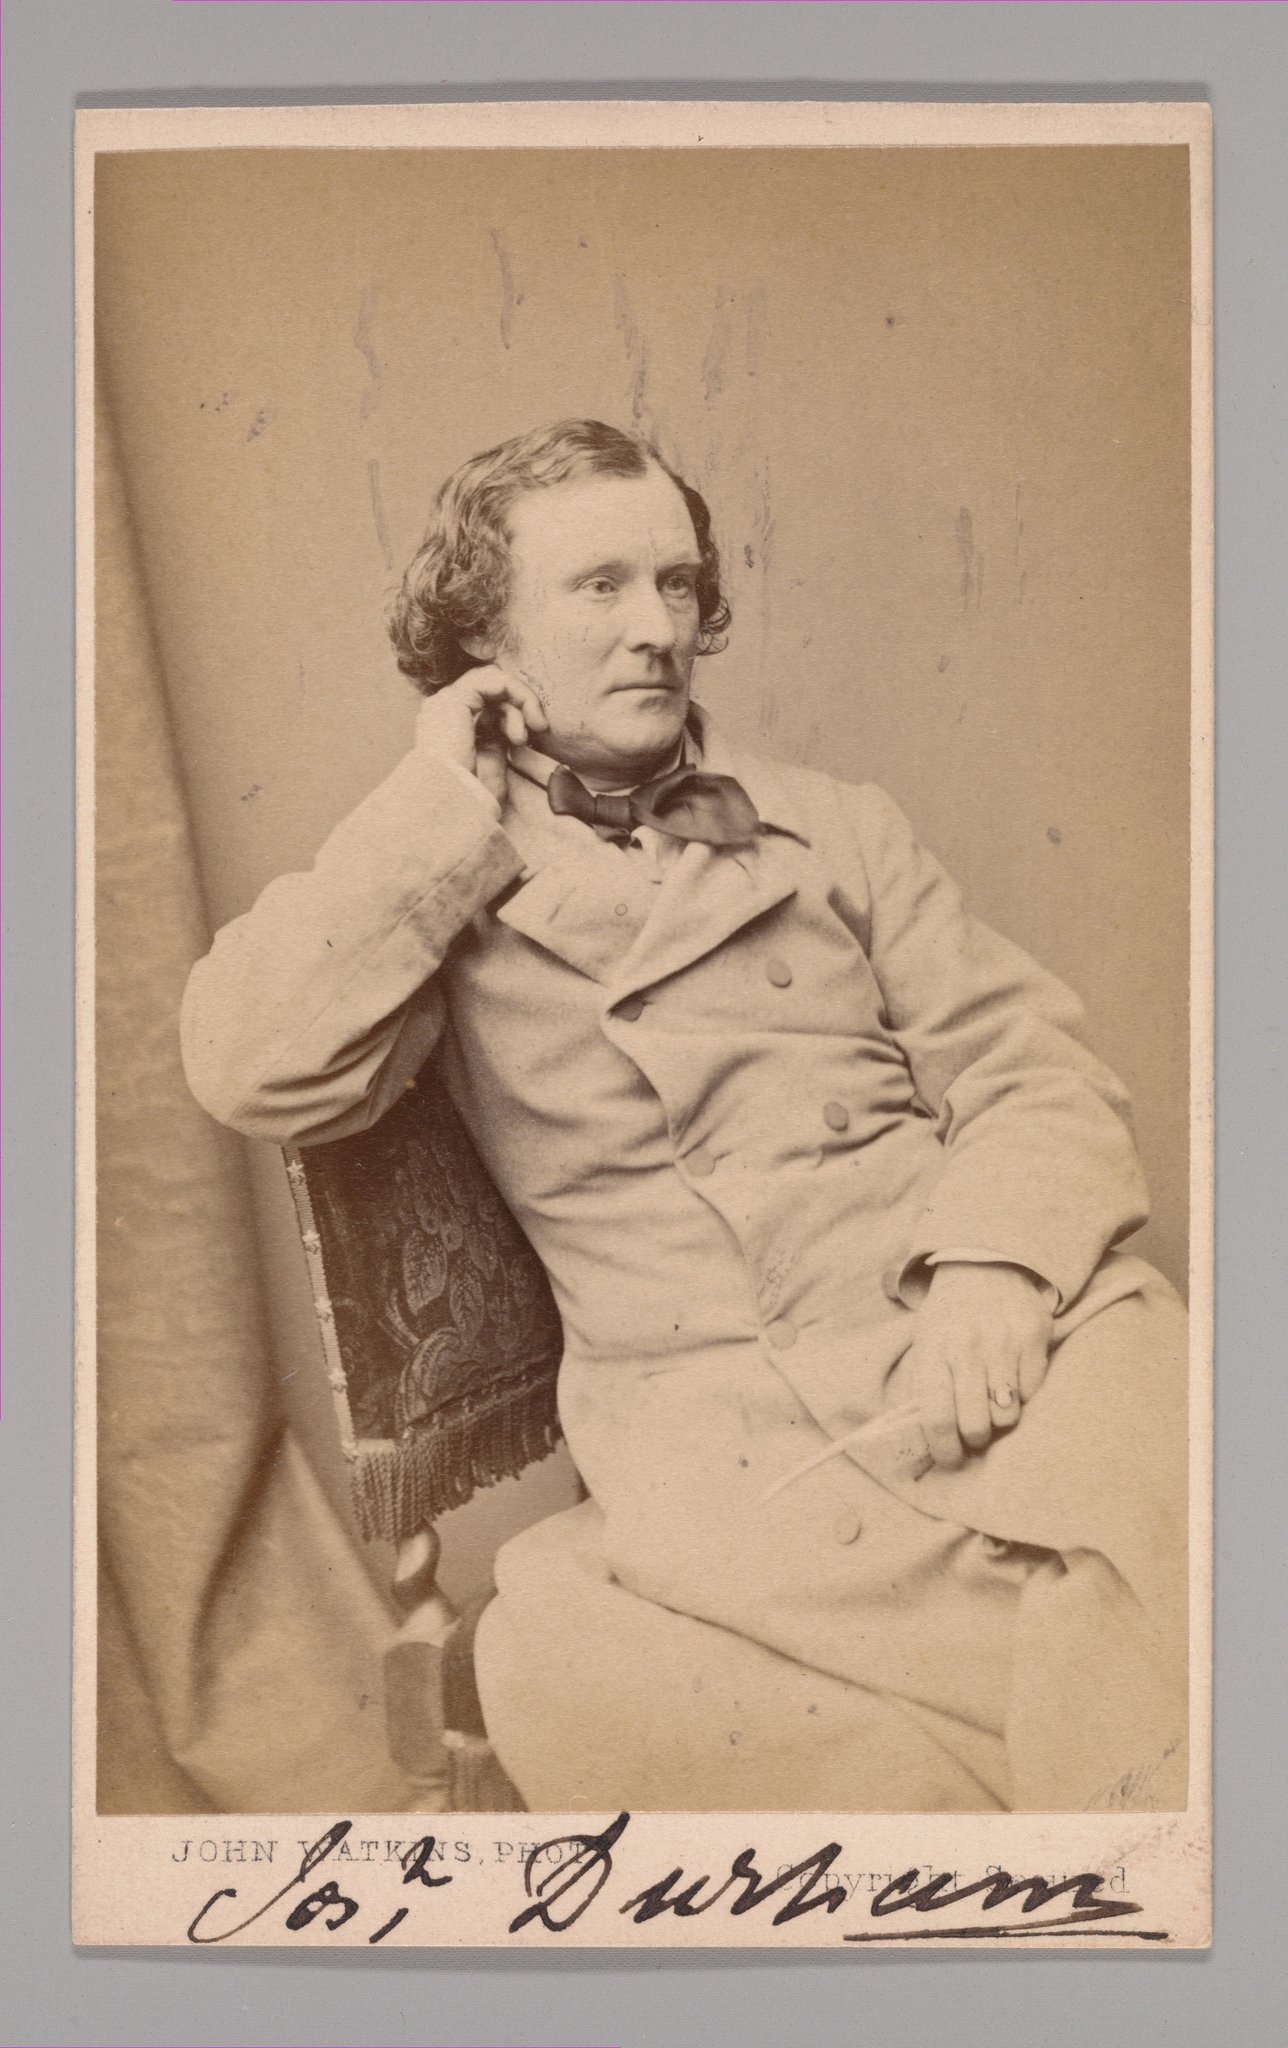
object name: carte de visite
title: [Joseph Durham]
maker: john and charles watkins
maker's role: photography studio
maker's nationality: british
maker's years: 1840-1875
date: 1860-1869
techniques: albumen silver print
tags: men,portraits